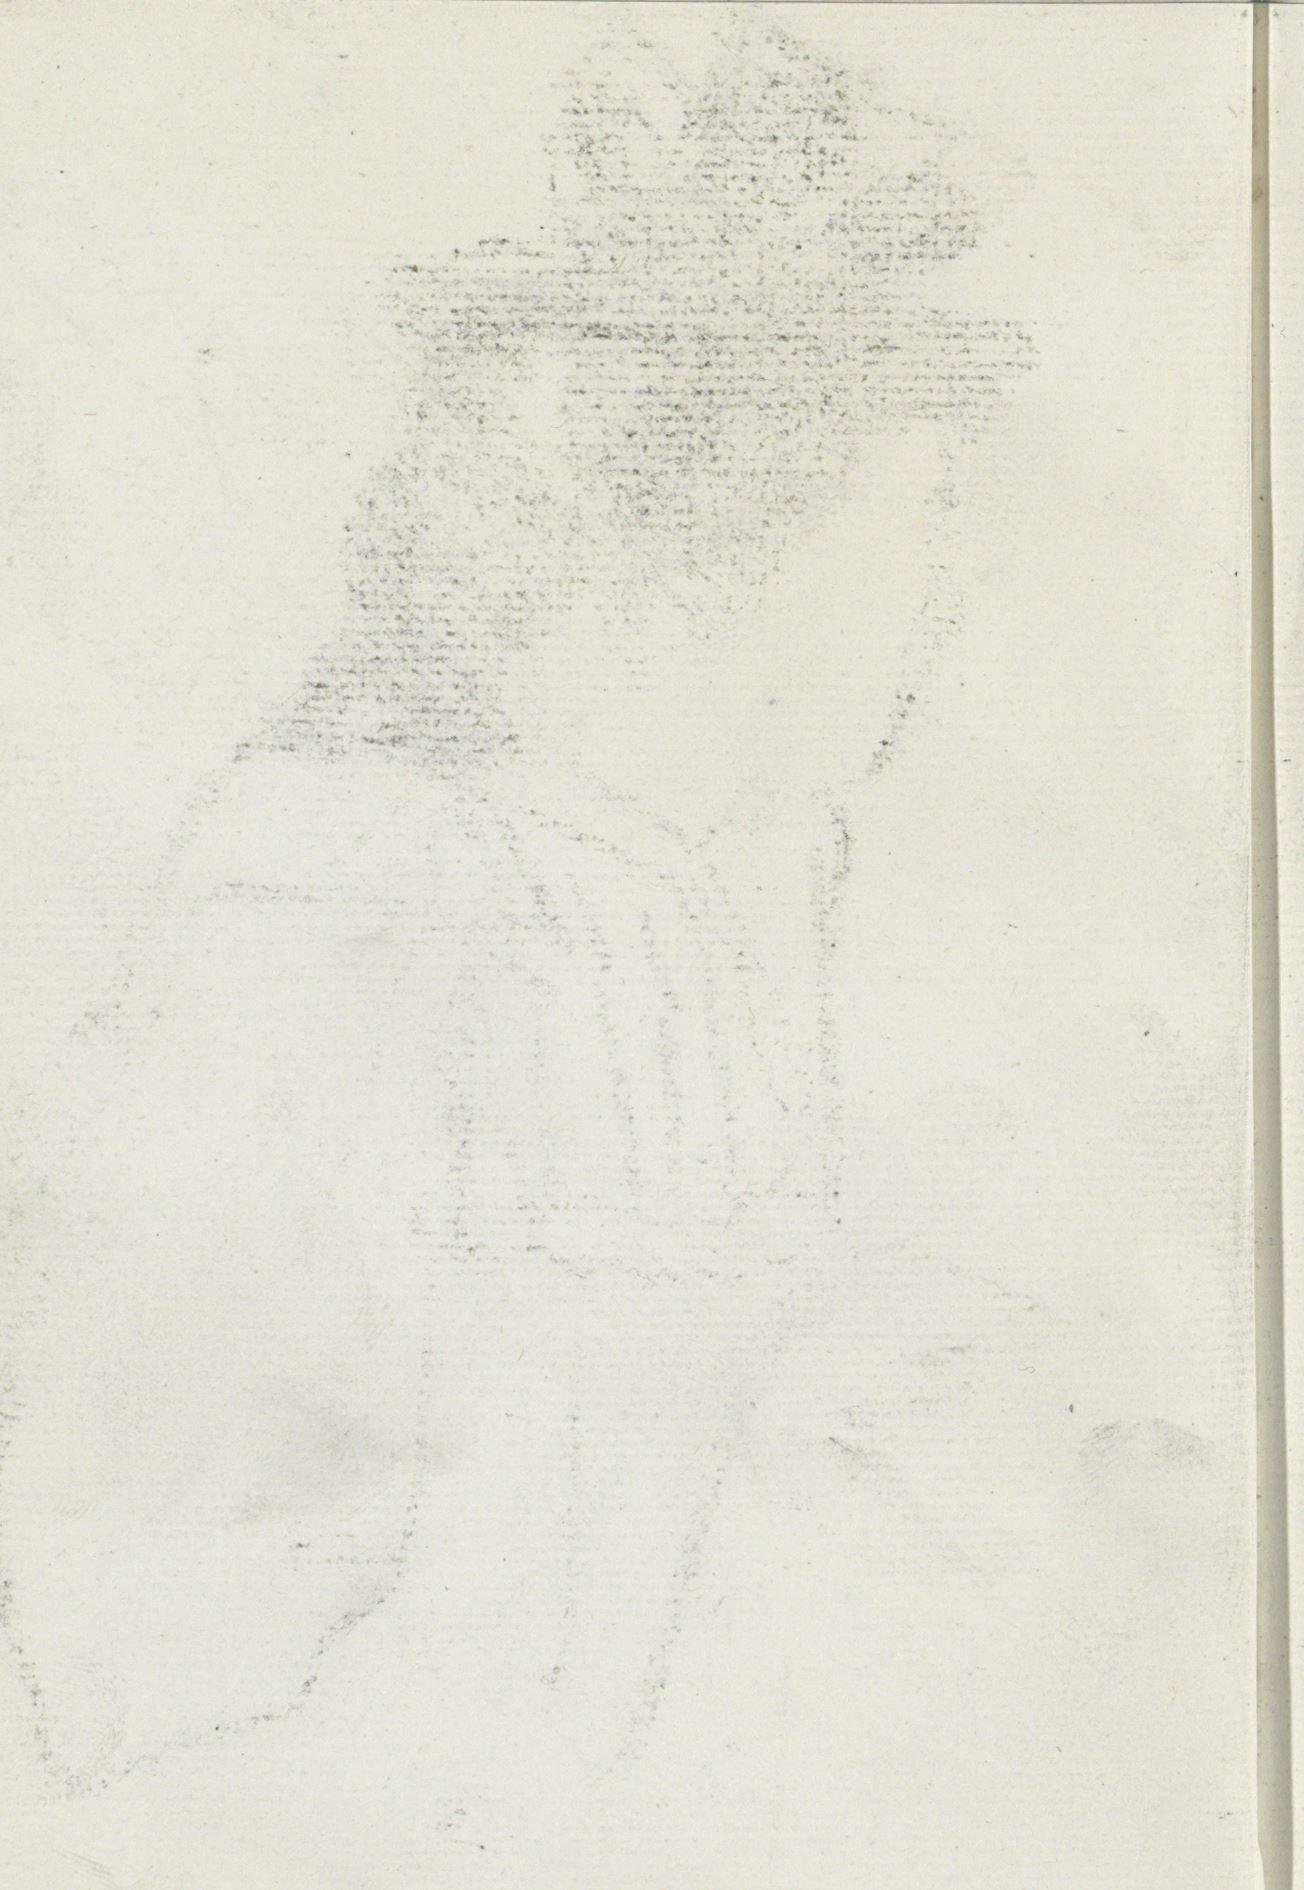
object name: sketchbook leaf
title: Abklatsch van de krijttekening op pagina 27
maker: isaac israels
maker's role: draughtsman, painter, print maker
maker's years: 1865-1934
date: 1886-1903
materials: paper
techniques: printmaking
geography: amsterdam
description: Pagina 26 uit schetsboek XXXVII met 52 pagina's.